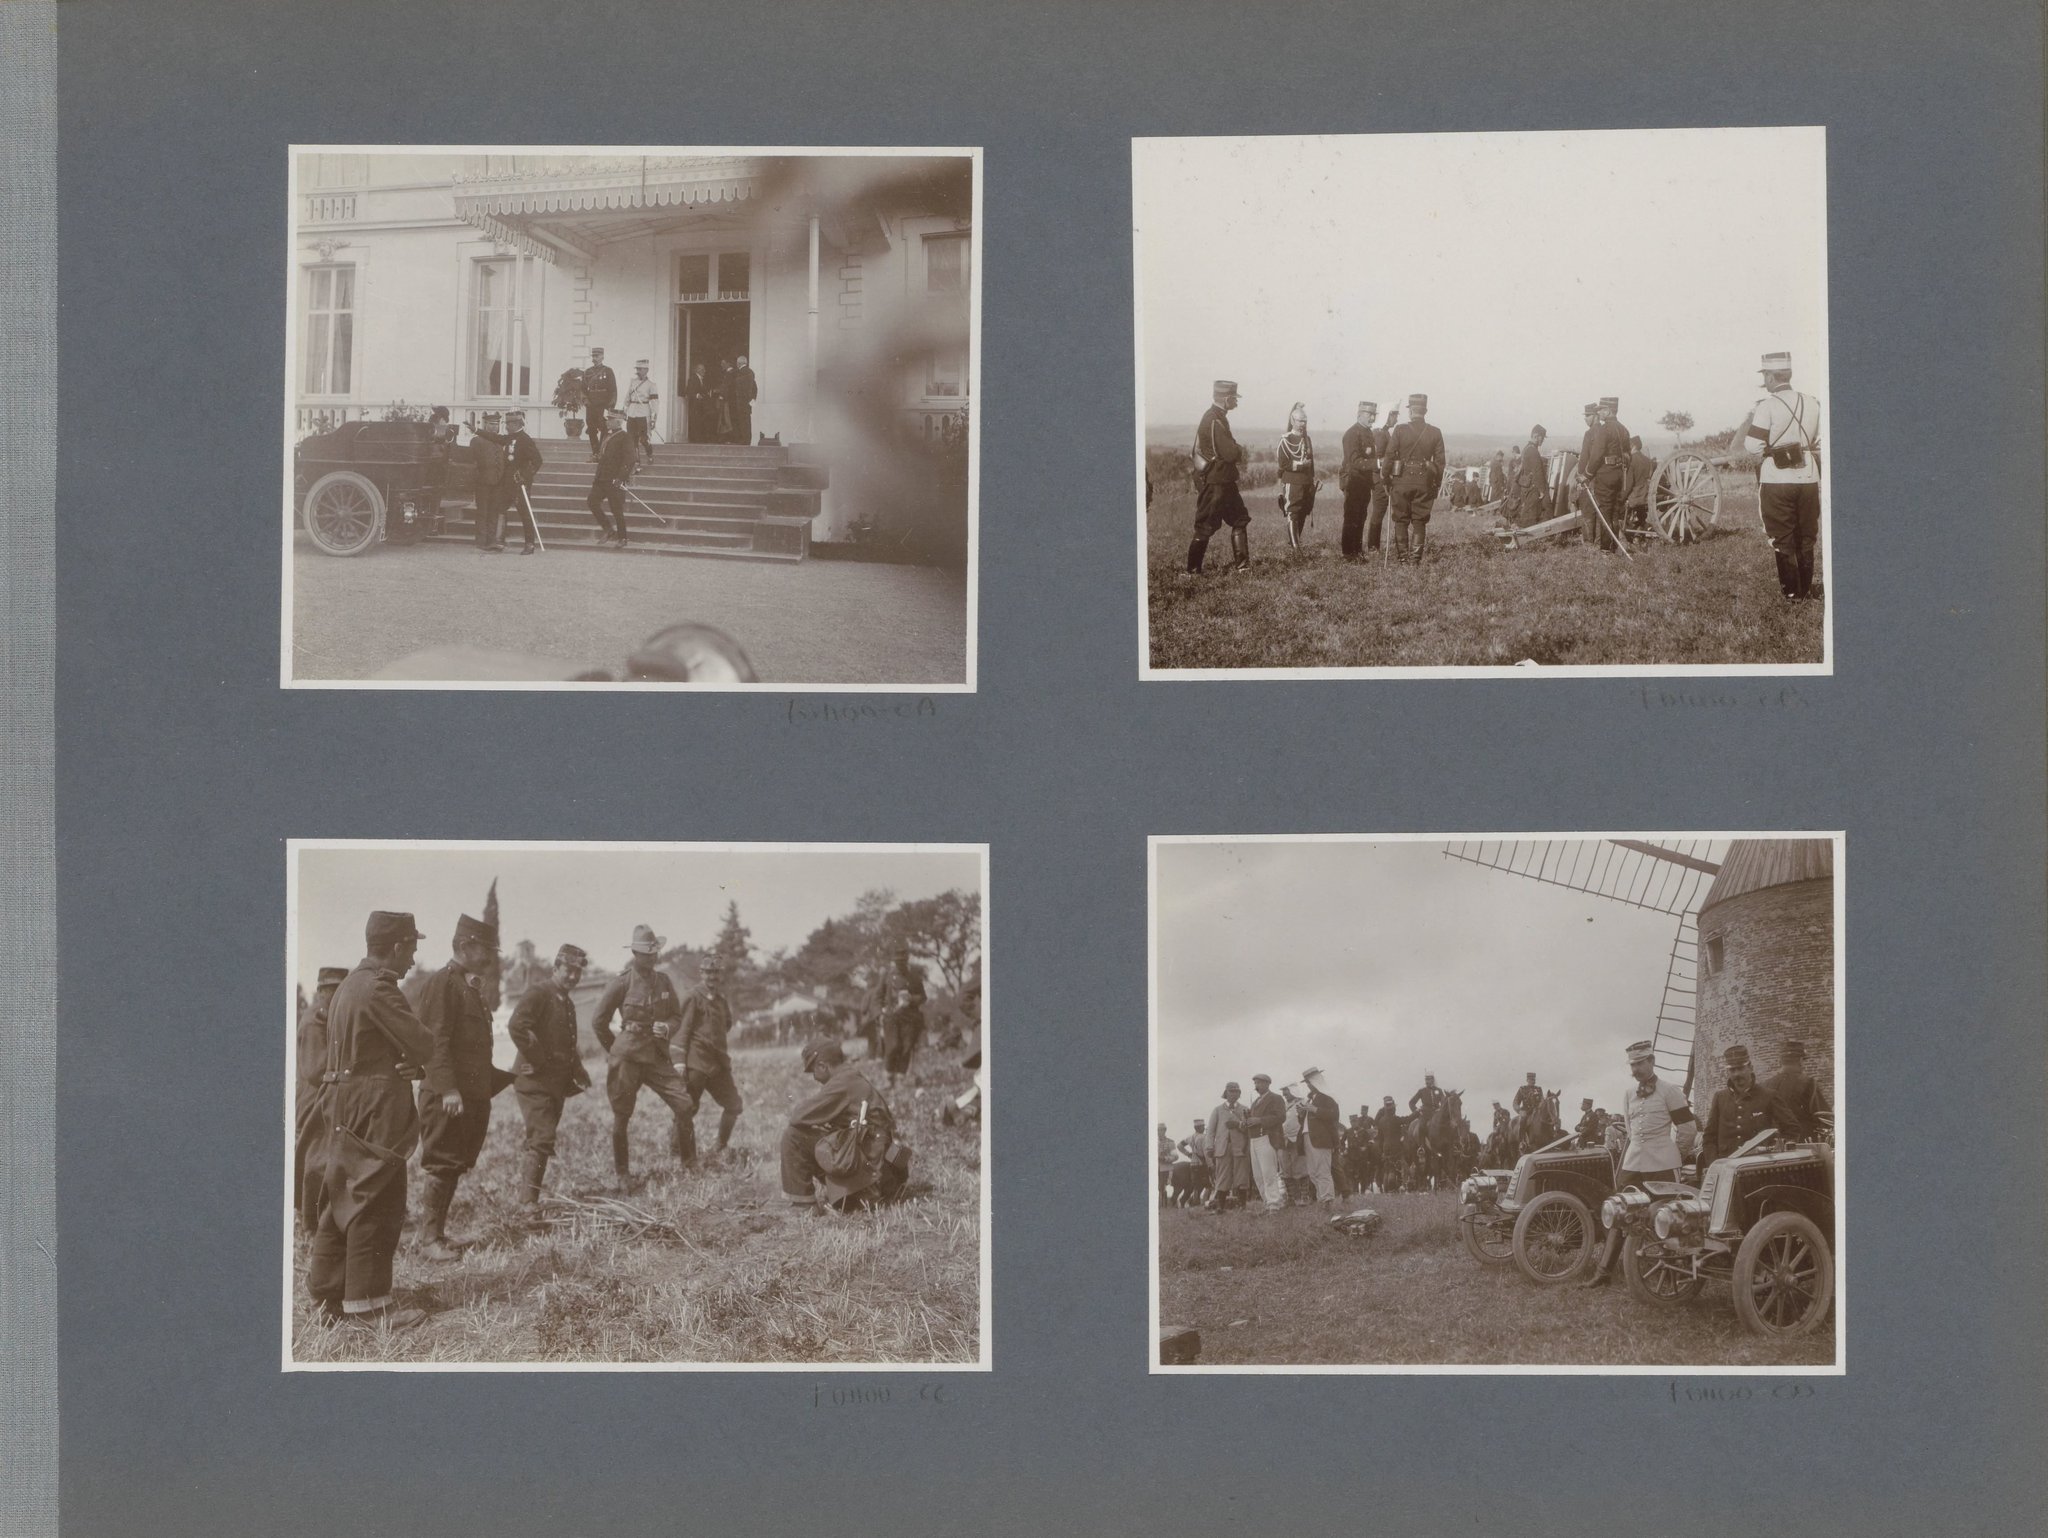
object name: album leaf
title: Militairen bij een kanon in een veld in Frankrijk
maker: Anonymous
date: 1902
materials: paper, photographic support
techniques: daylight paper print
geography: france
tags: land forces (+ artillery), firearms: cannon (+ land forces), manoeuvre ~ military training, land forces, france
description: Onderdeel van Fotoalbum van een legeroefening in Zuidwest-Frankrijk in 1902.